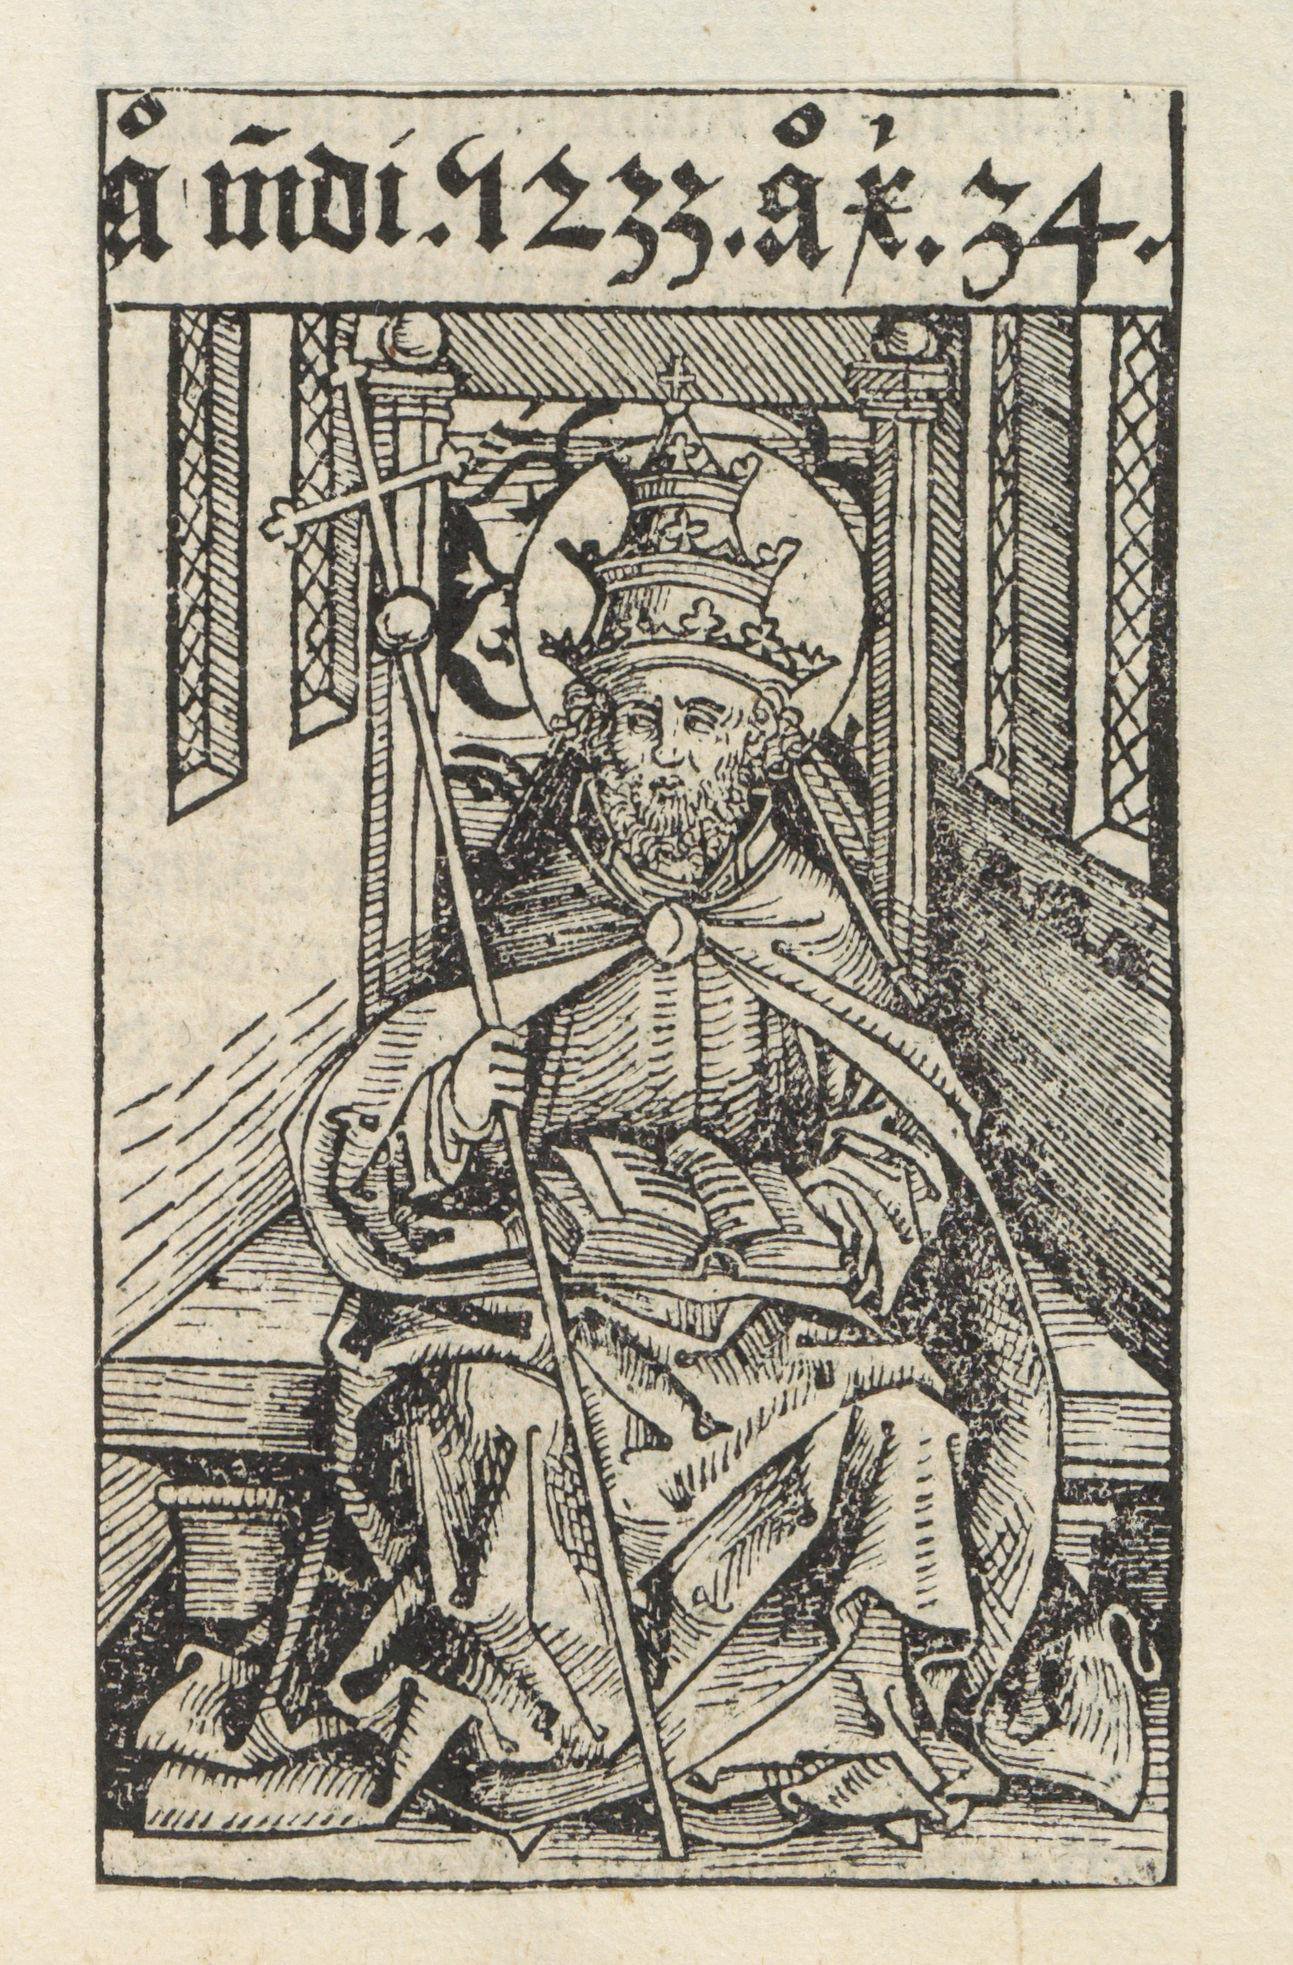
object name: album leaf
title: Liber Chronicarum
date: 1493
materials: paper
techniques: letterpress printing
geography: nuremberg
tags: st. peter as first bishop of rome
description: De heilige Petrus, zittend op een troon in een ruimte met vier ramen. Hij draagt een tiara op zijn hoofd en een bisschopsstaf in zijn rechter hand. Op zijn schoot ligt een boek. De prent maakt deel uit van een album.